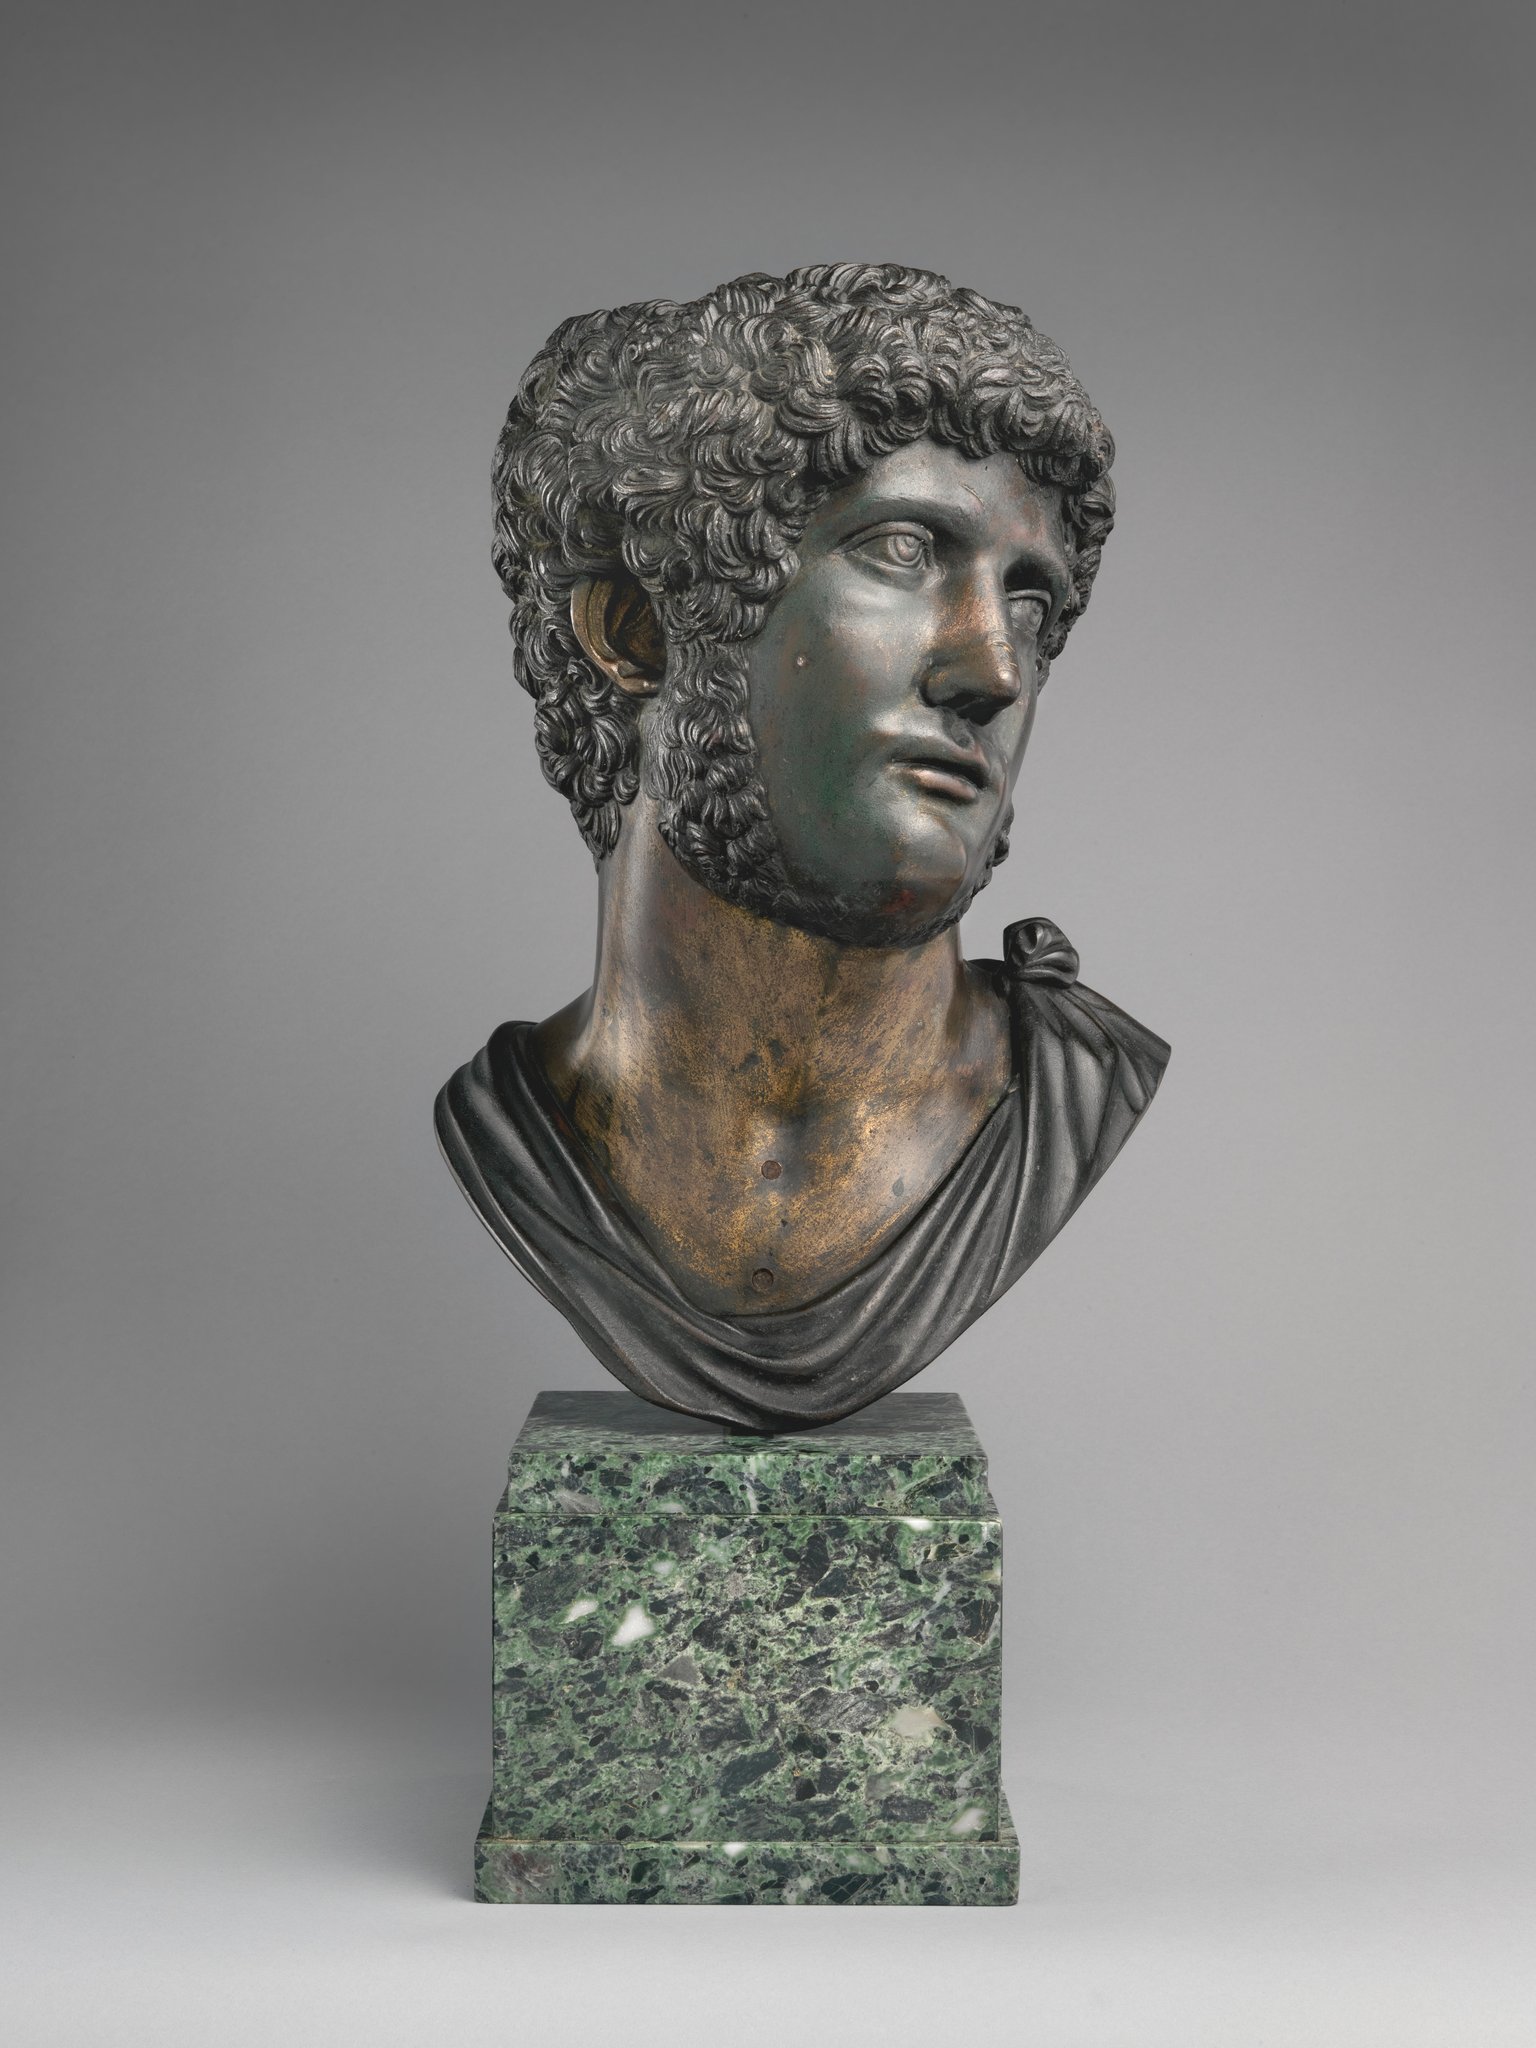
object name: bust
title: The young Hadrian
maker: guglielmo della porta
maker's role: artist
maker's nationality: italian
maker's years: 1500-1577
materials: bronze, stone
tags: men